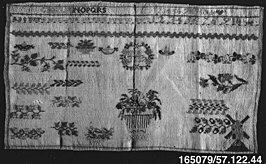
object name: sampler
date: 1837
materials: wool